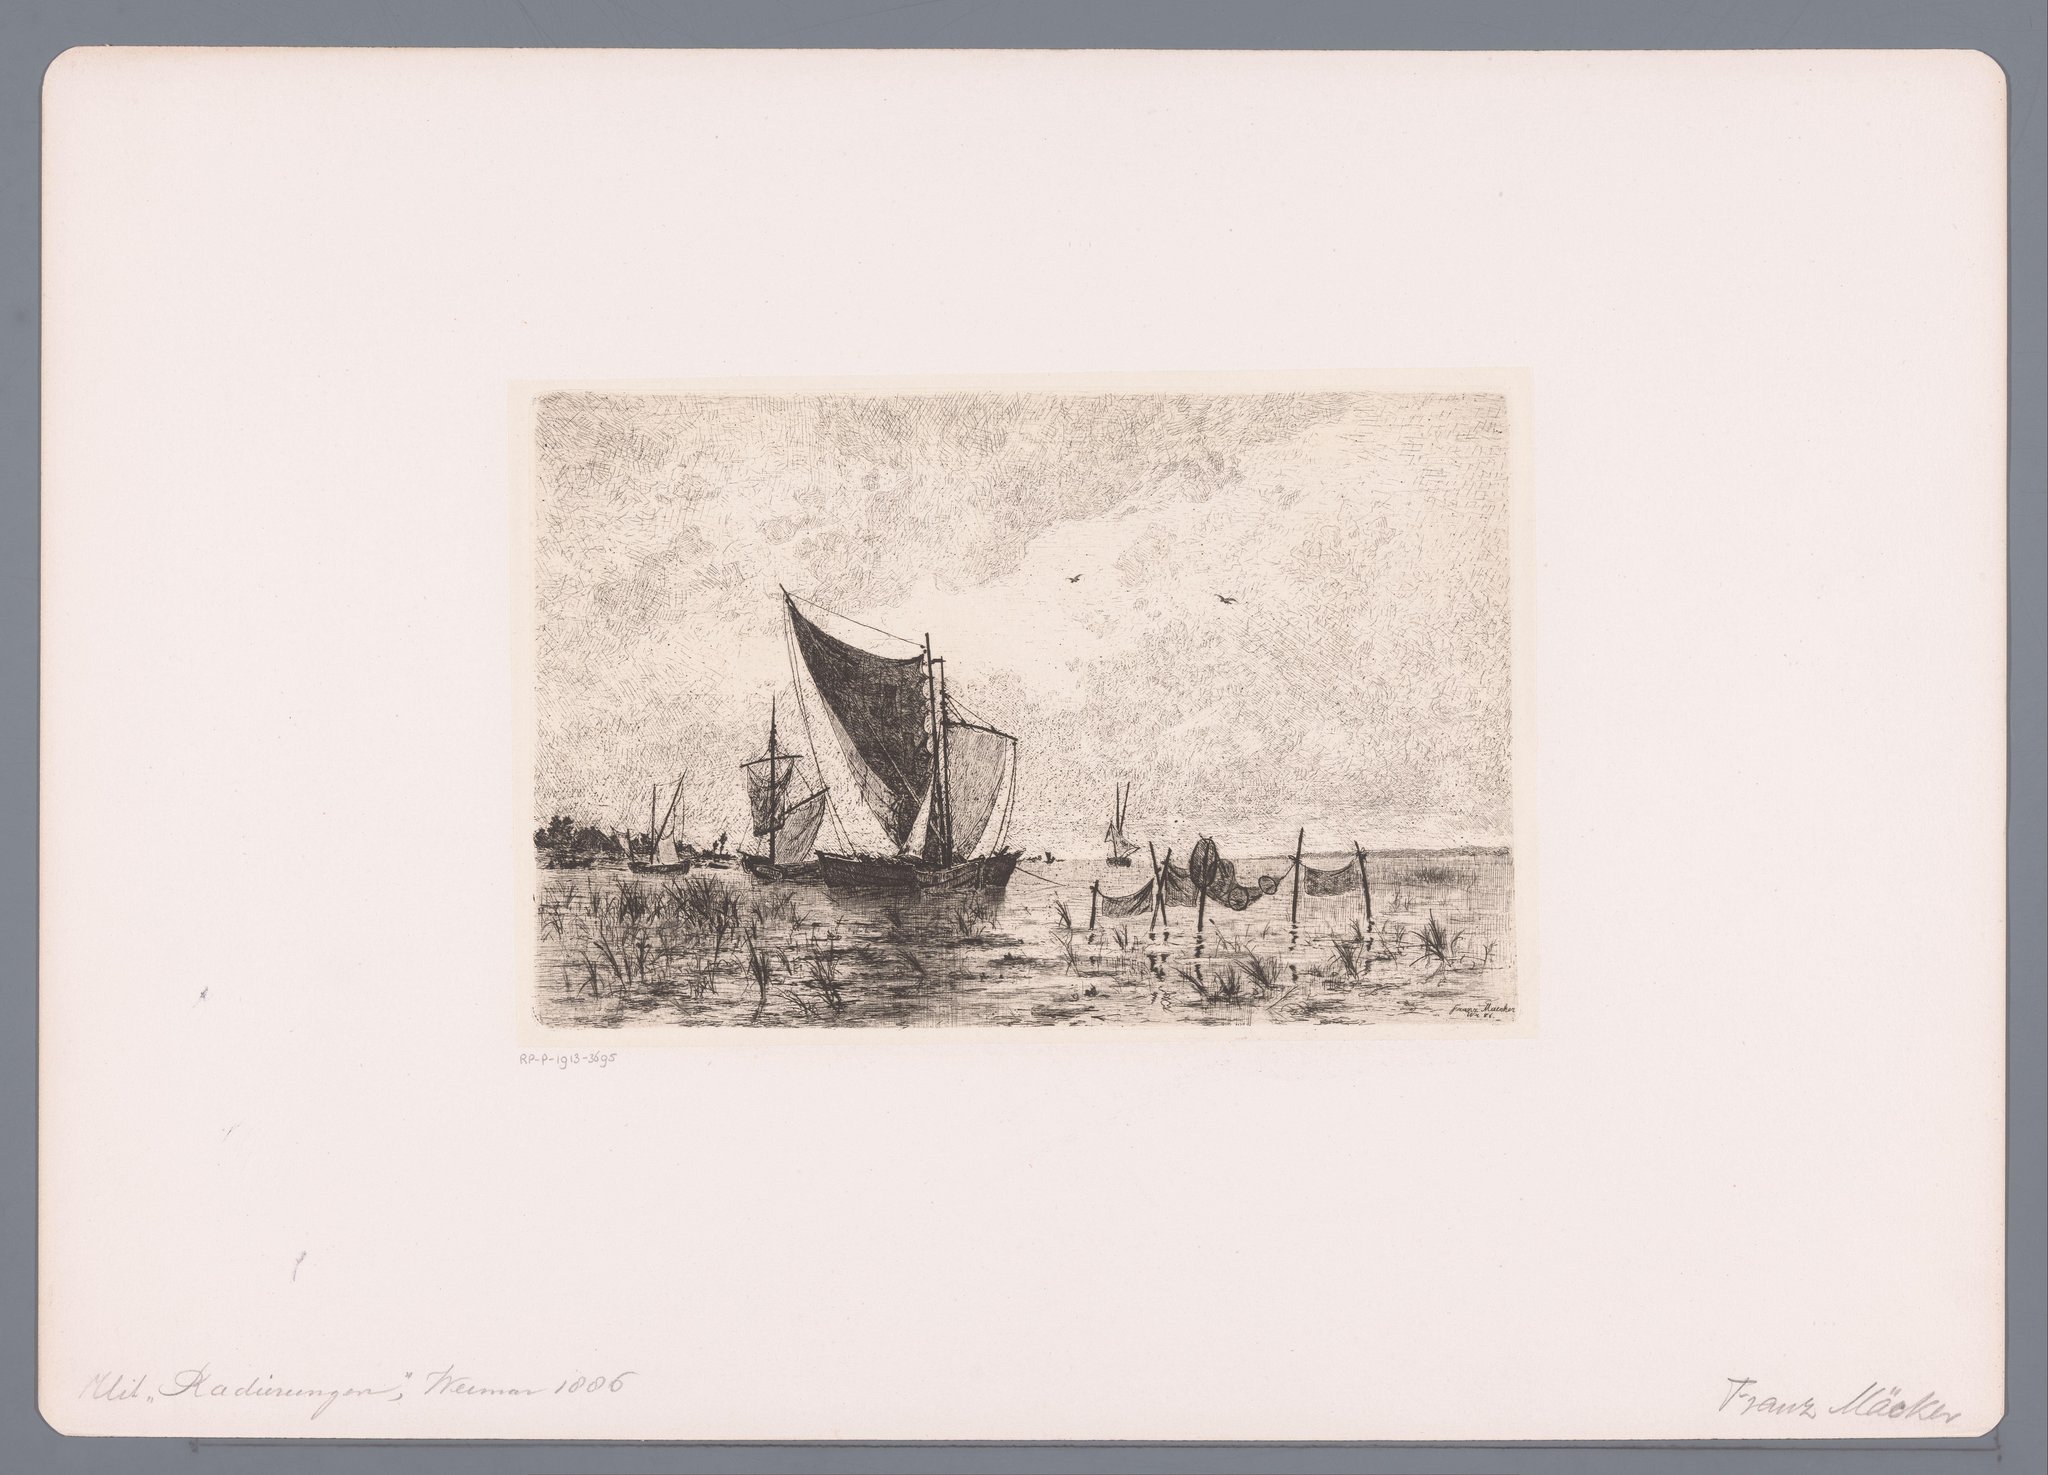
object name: print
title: Zeilboten op kalm water en enkele visnetten aan palen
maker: franz maecker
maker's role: print maker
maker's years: 1855-1913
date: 1886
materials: paper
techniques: etching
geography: weimar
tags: fishing net, ships (in general)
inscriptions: collector's mark: Lugt 2228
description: Prent maakt deel uit van een groep prenten die tussen 1880 en 1888 werd uitgegeven door het Gesellschaft für Radierkunst te Weimar.